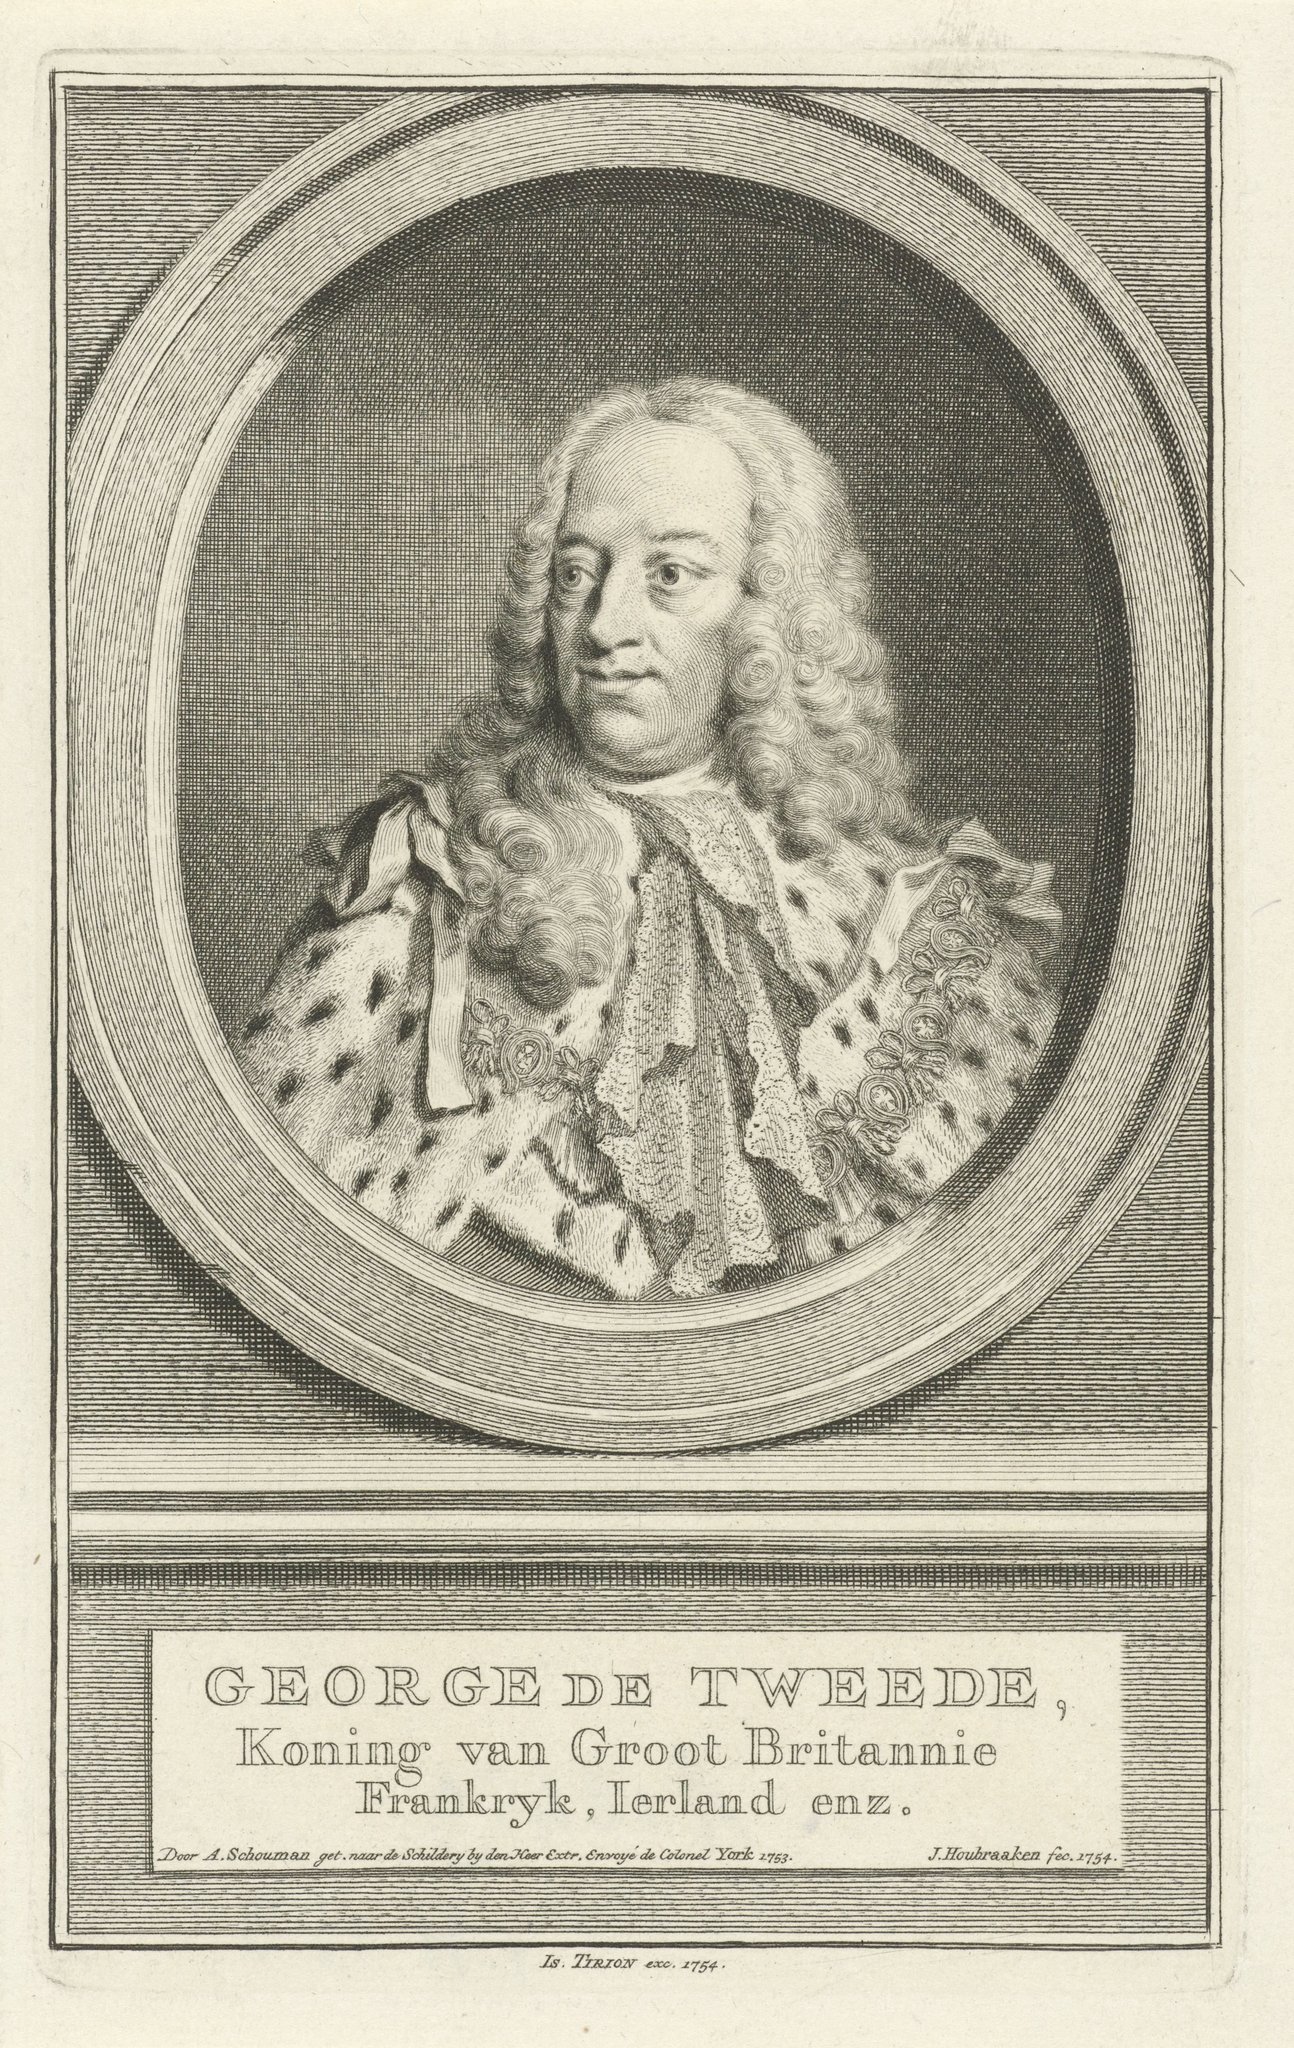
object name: print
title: Portret van George II Augustus, koning van Engeland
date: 1754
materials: paper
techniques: engraving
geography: amsterdam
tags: london, george ii augustus (koning van groot-brittannië)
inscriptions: collector's mark: Lugt 2228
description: George II Augustus, koning van Engeland, gekleed in een koningsmantel. Buste in ovaal, rustend op een plint waarop zijn naam en titel in drie regels in het Nederlands.